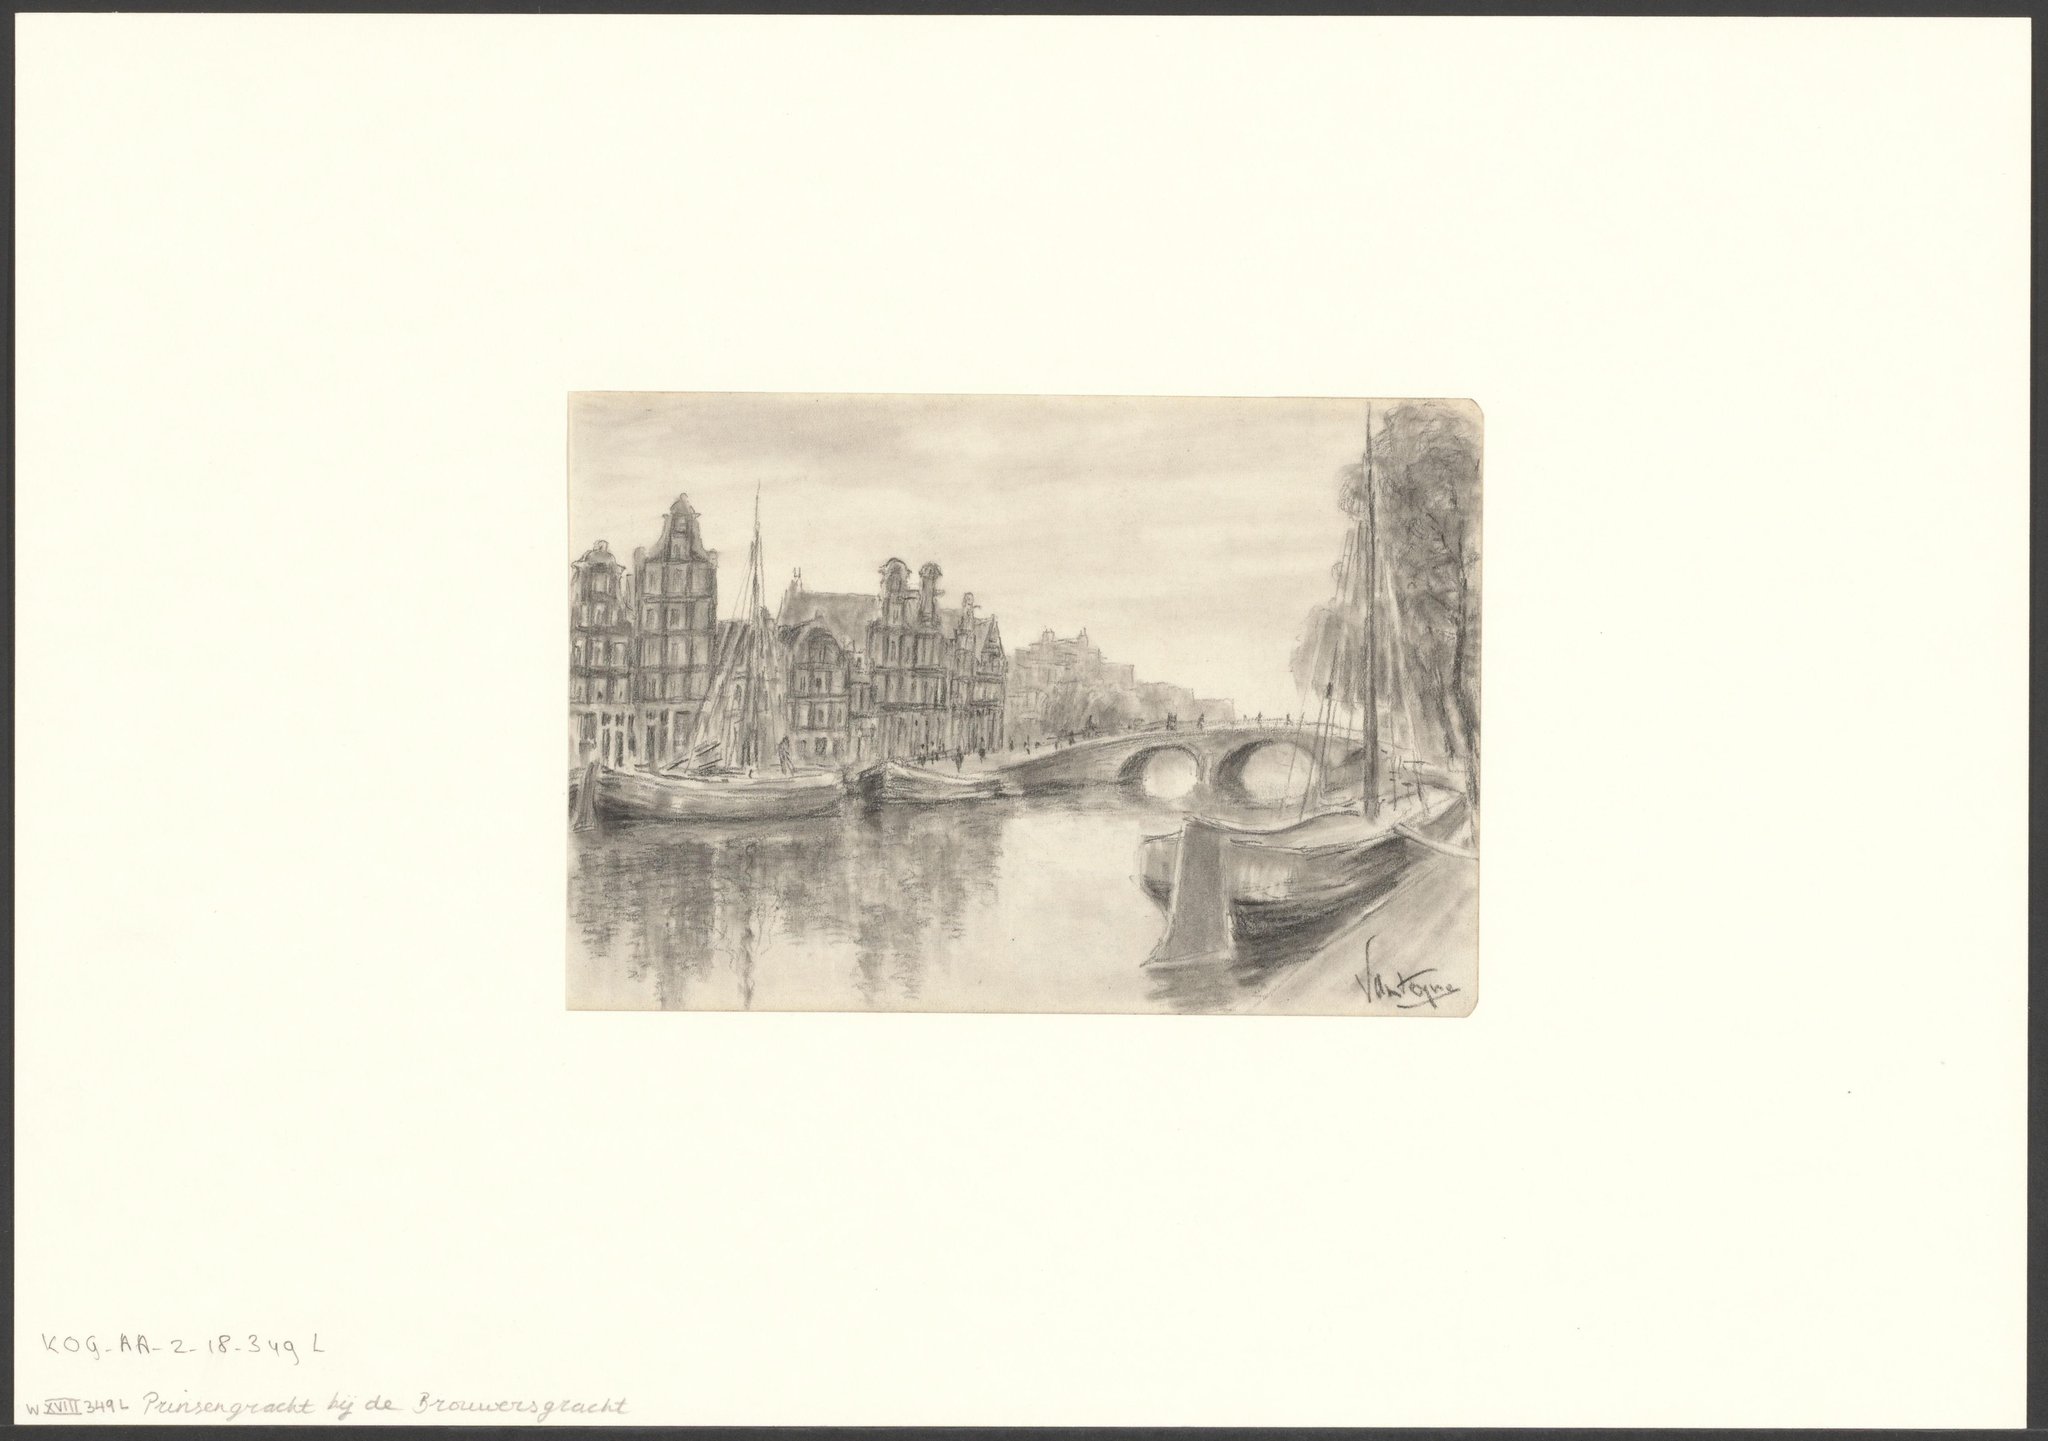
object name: drawing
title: Gezicht op de Prinsengracht bij de Brouwersgracht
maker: anthonie van teijn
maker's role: draughtsman, painter, print maker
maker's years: 1863-1943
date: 1906-1927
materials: chalk, paper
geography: amsterdam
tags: sailing-ship, sailing-boat, city-view in general; 'veduta', canal, bridge in city across river, canal, etc.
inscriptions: inscription: ‘Noordermarkt - 5. het (...) Juni 1927. / VEck’, signature: ‘VanTeyne’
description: Tekening binnen de Atlas Van Eck ingedeeld op wijknummer 18.